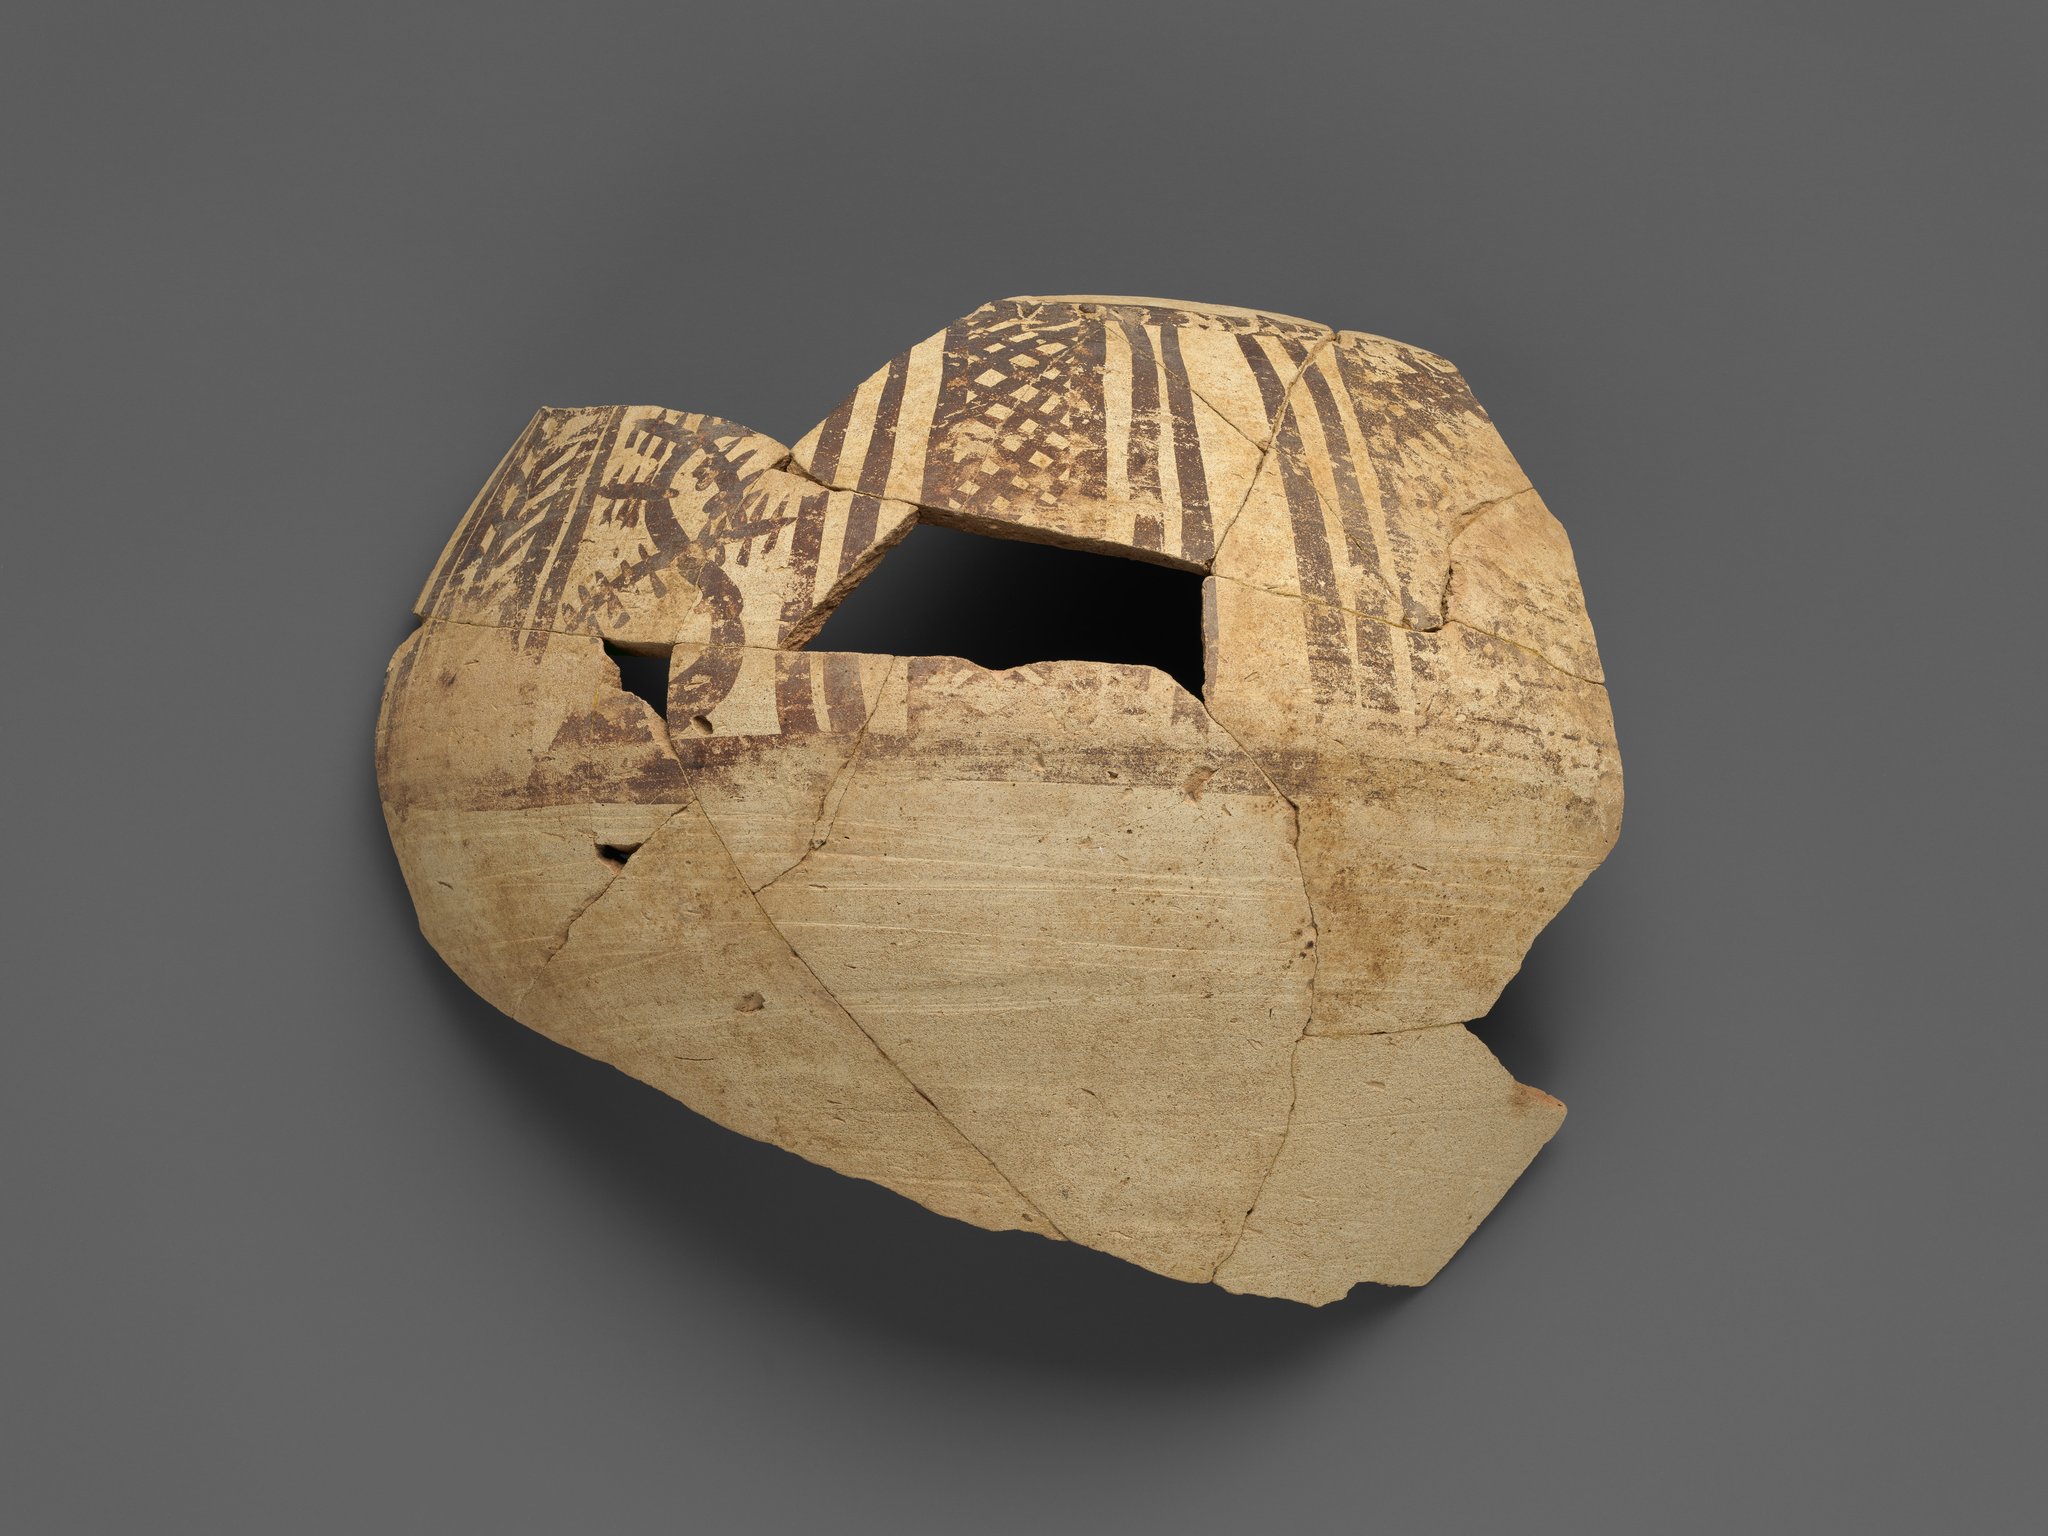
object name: jar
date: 3100-2900 BCE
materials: ceramic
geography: mesopotamia